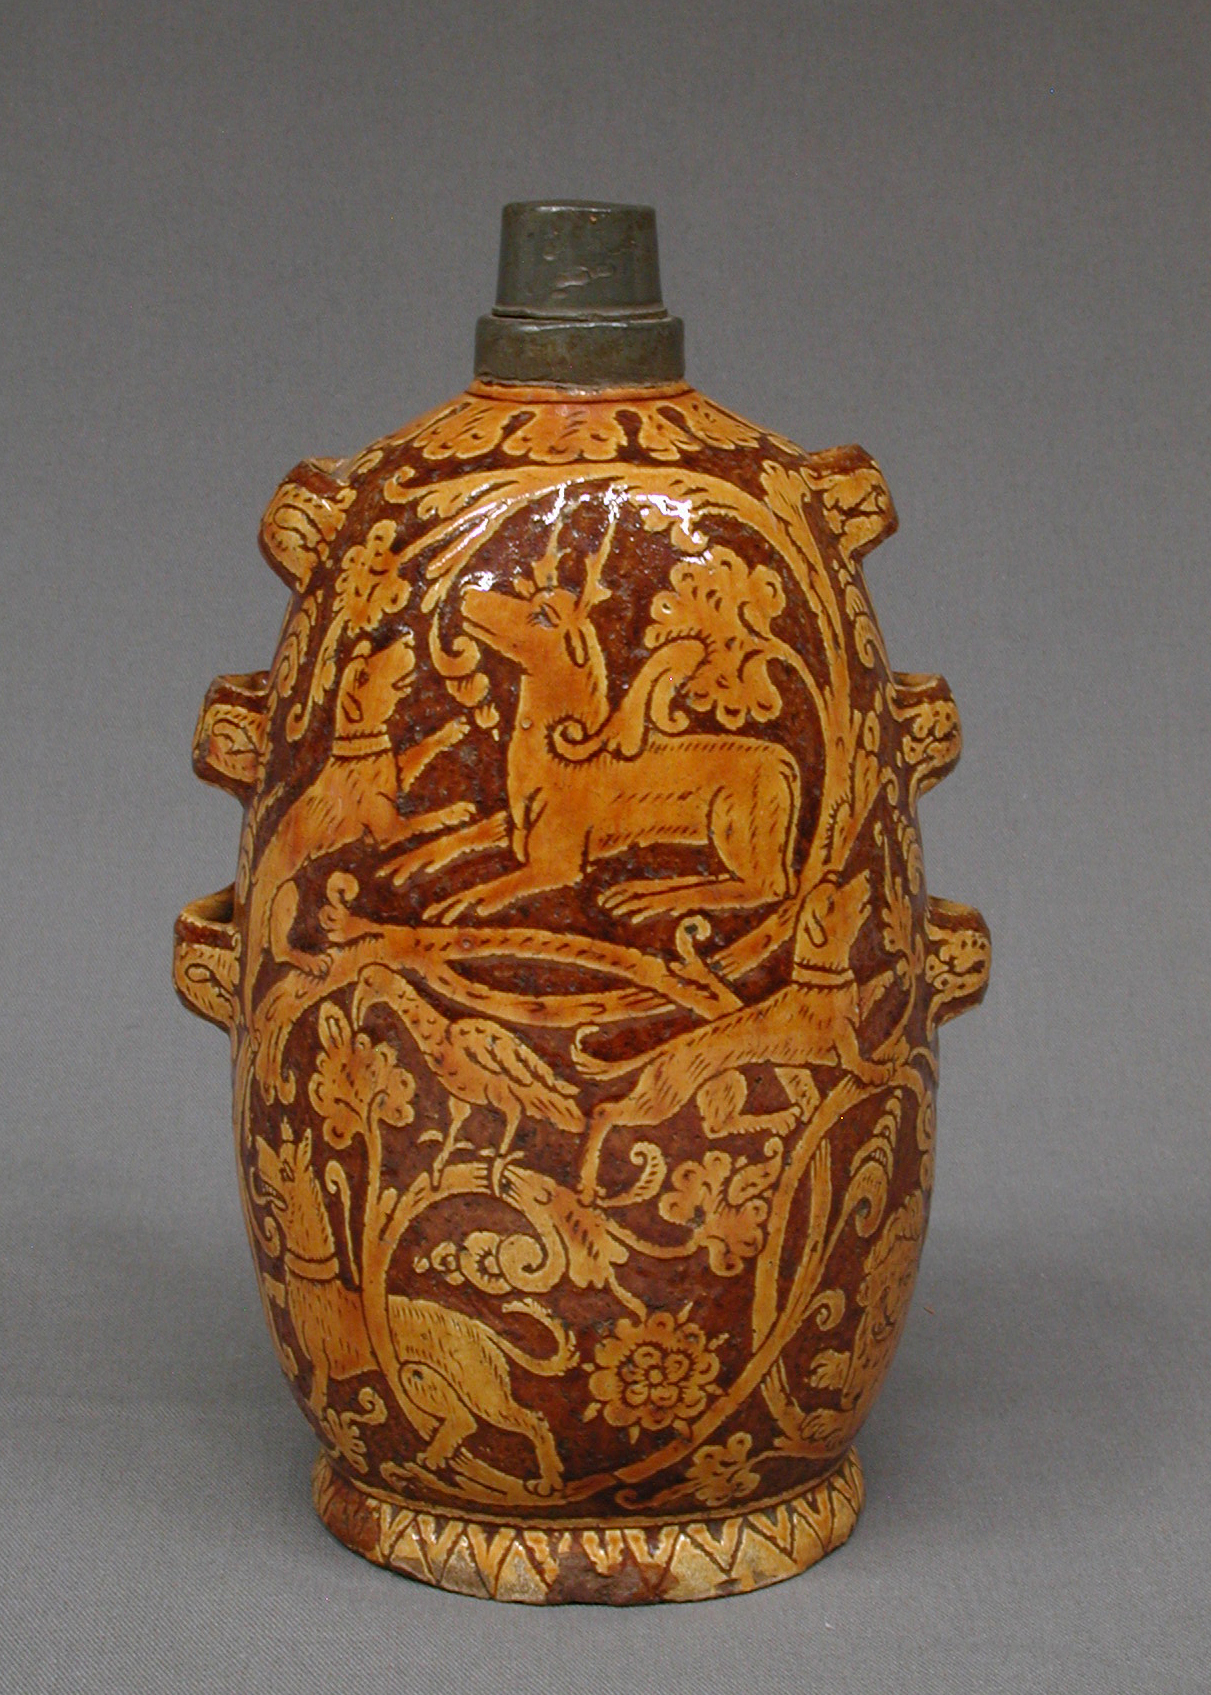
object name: pilgrim bottle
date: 1650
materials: pewter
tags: birds,deer,dogs